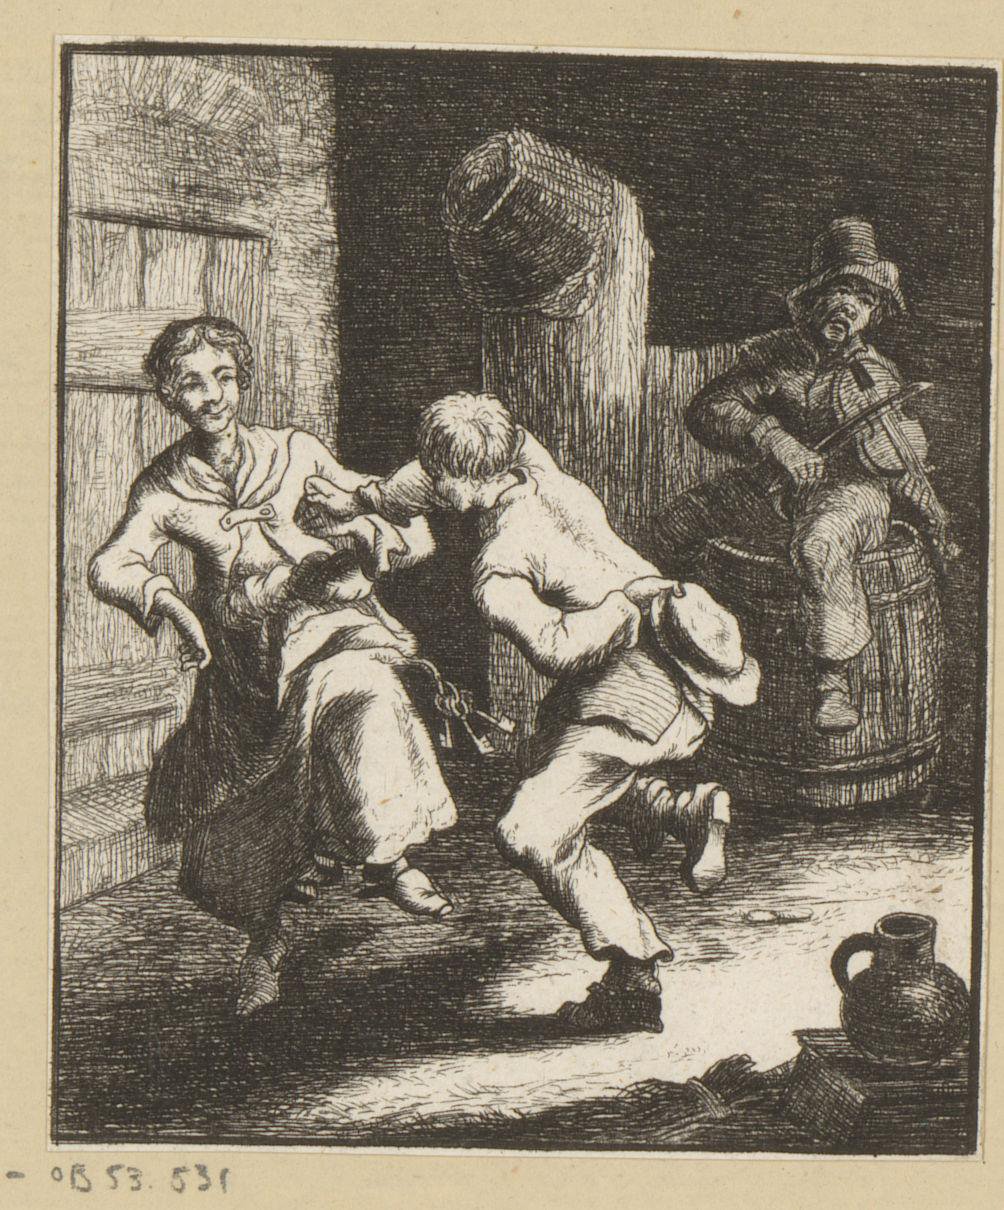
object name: print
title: Man en vrouw dansend op muziek van vioolspeler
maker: carl august grossmann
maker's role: print maker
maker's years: 1741-1798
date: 1760-1798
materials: paper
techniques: etching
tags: one person playing string instrument (bowed), one pair dancing; man and woman dancing as a couple, drinking, hotel, hostelry, inn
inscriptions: collector's mark: Lugt 240